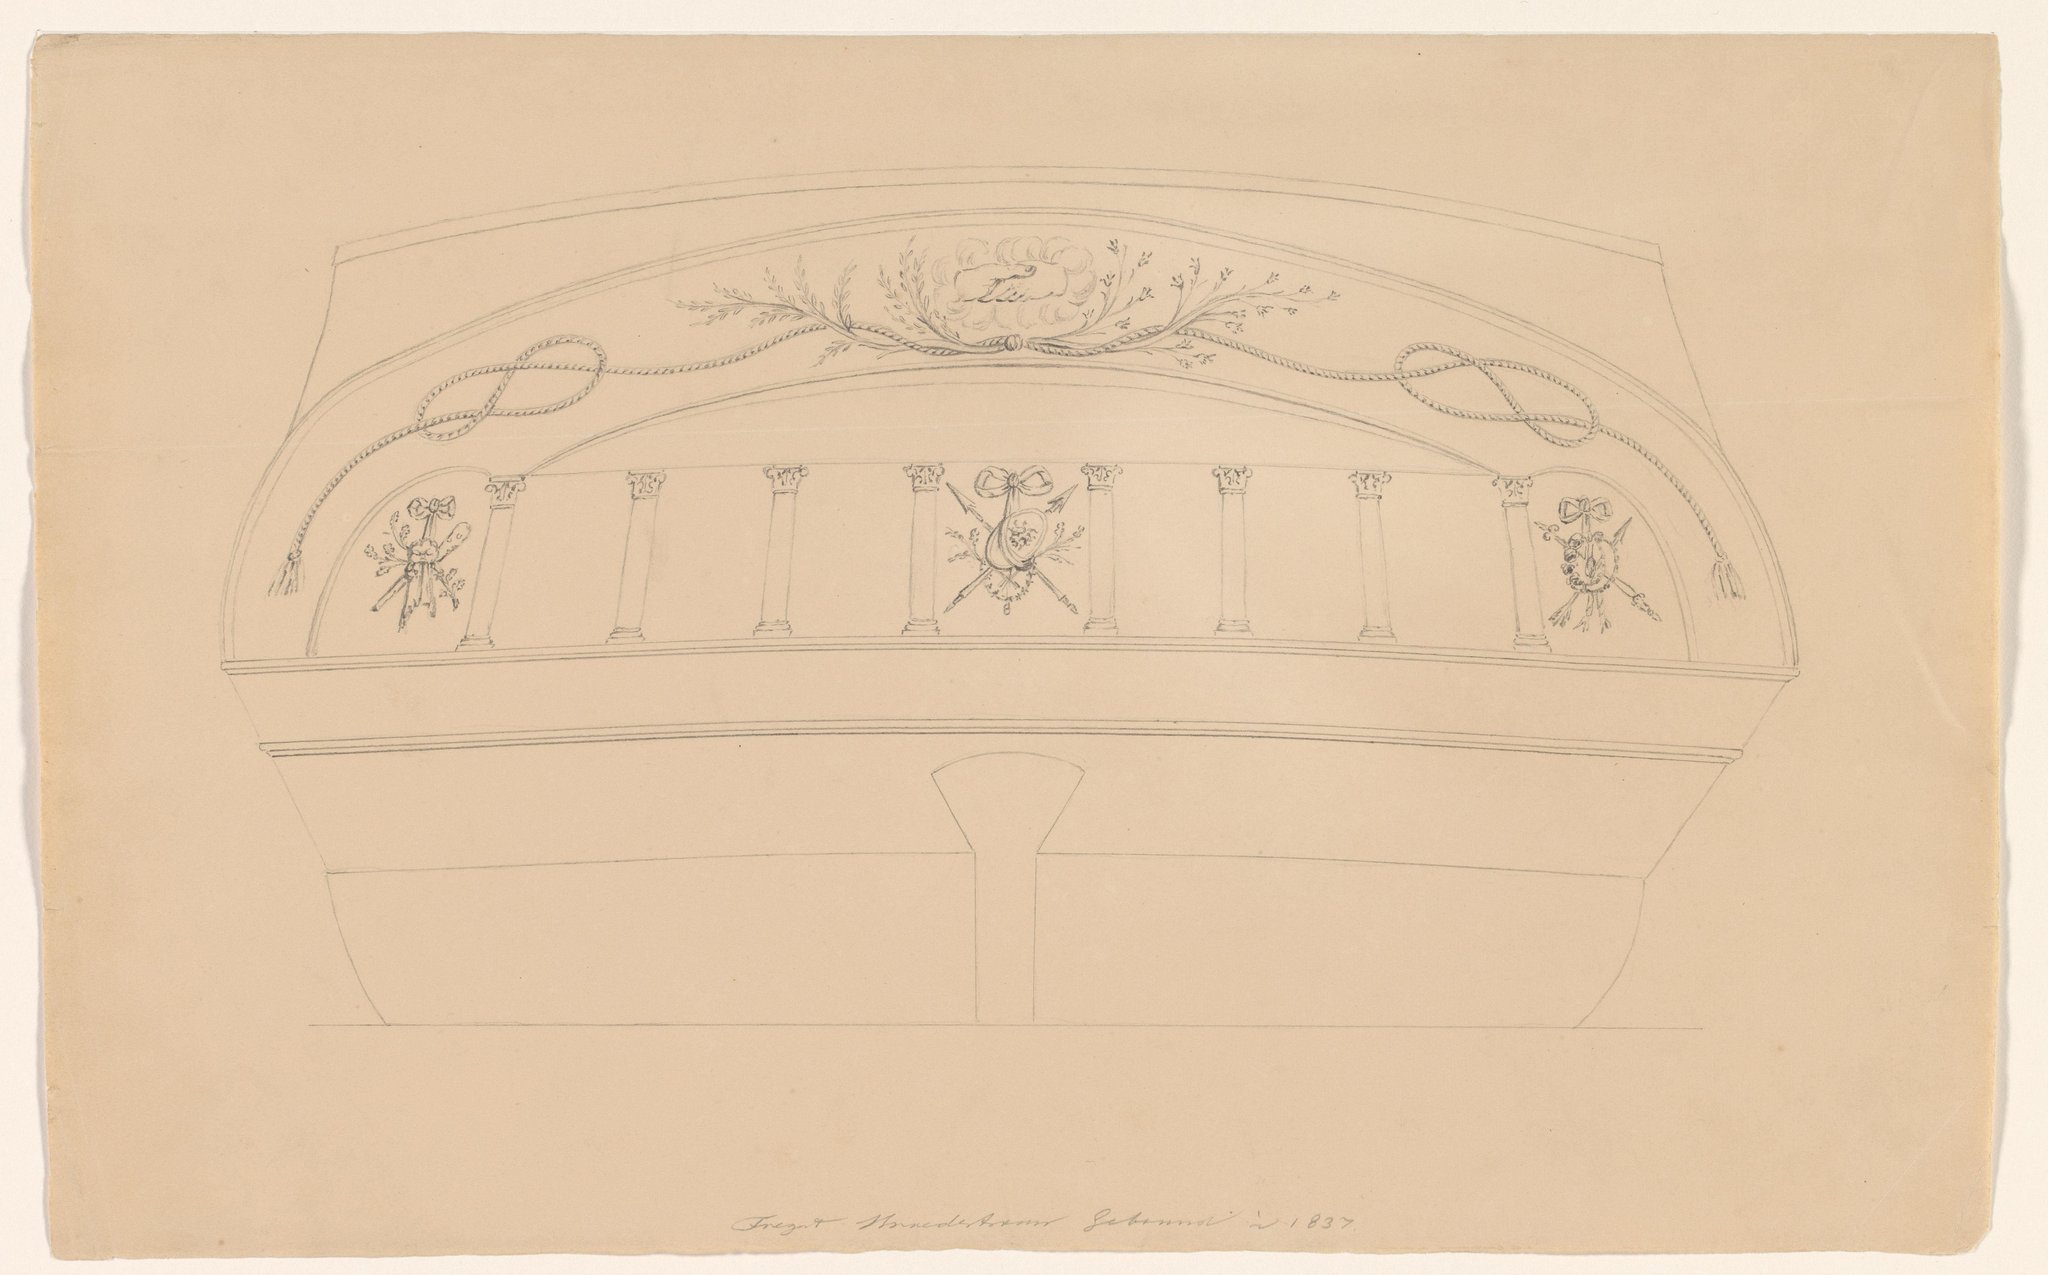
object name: drawing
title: Ontwerp voor de spiegel van het fregat Delta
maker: a.j. schouten (1775-1849)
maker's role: architect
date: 1839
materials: paper, pencil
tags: parts of ship's exterior: stern, ornamenting, decorating ~ applied arts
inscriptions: watermark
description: Ontwerp met een driehoek, sterren en knoopmotief.